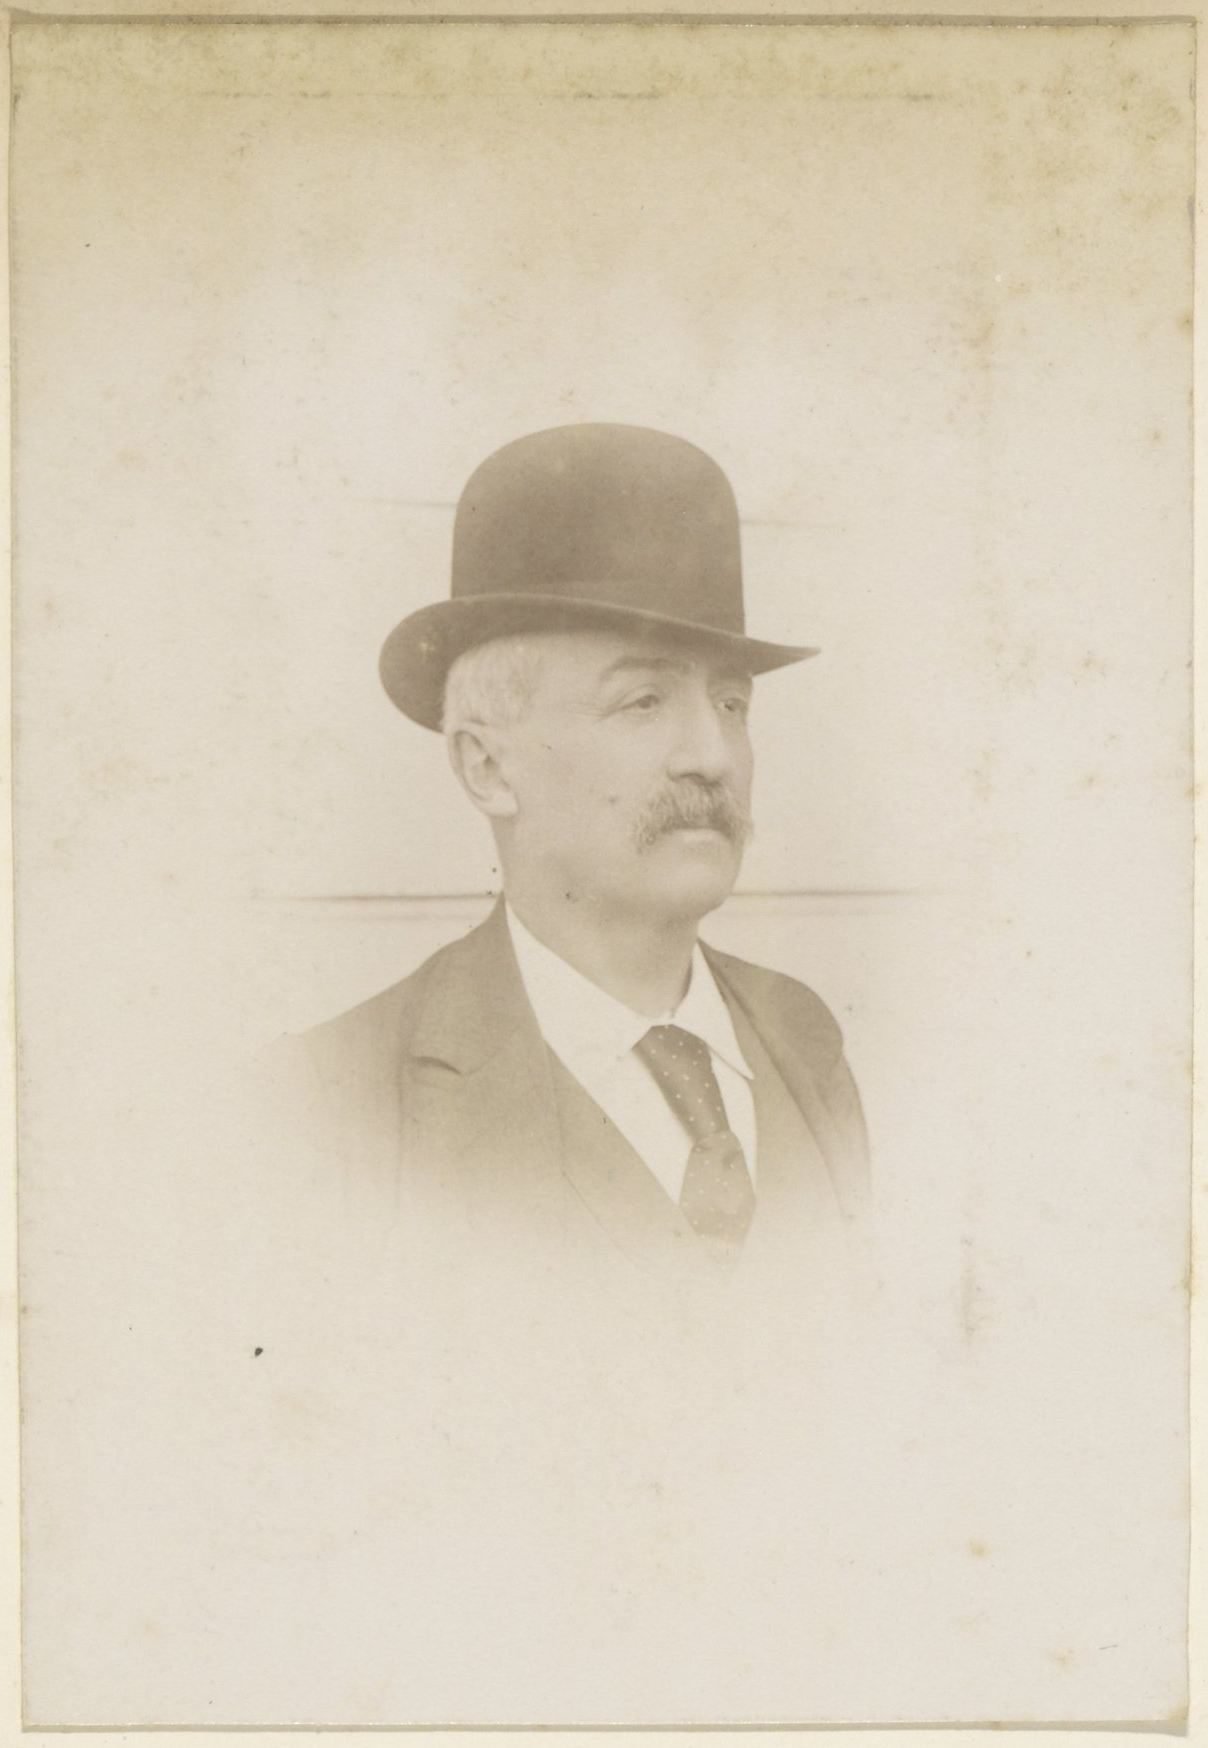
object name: photograph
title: Portret van een Franse man met een bolhoed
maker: Anonymous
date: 1900-1910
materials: paper, photographic support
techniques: albumen print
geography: france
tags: head-gear: bowler hat, adult man, france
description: Onderdeel van Fotoalbum van een Franse amateurfotograaf met opnames van een familie, distilleerderij Delizy & Doistau Fils, het leger en bezienswaardigheden in Frankrijk.